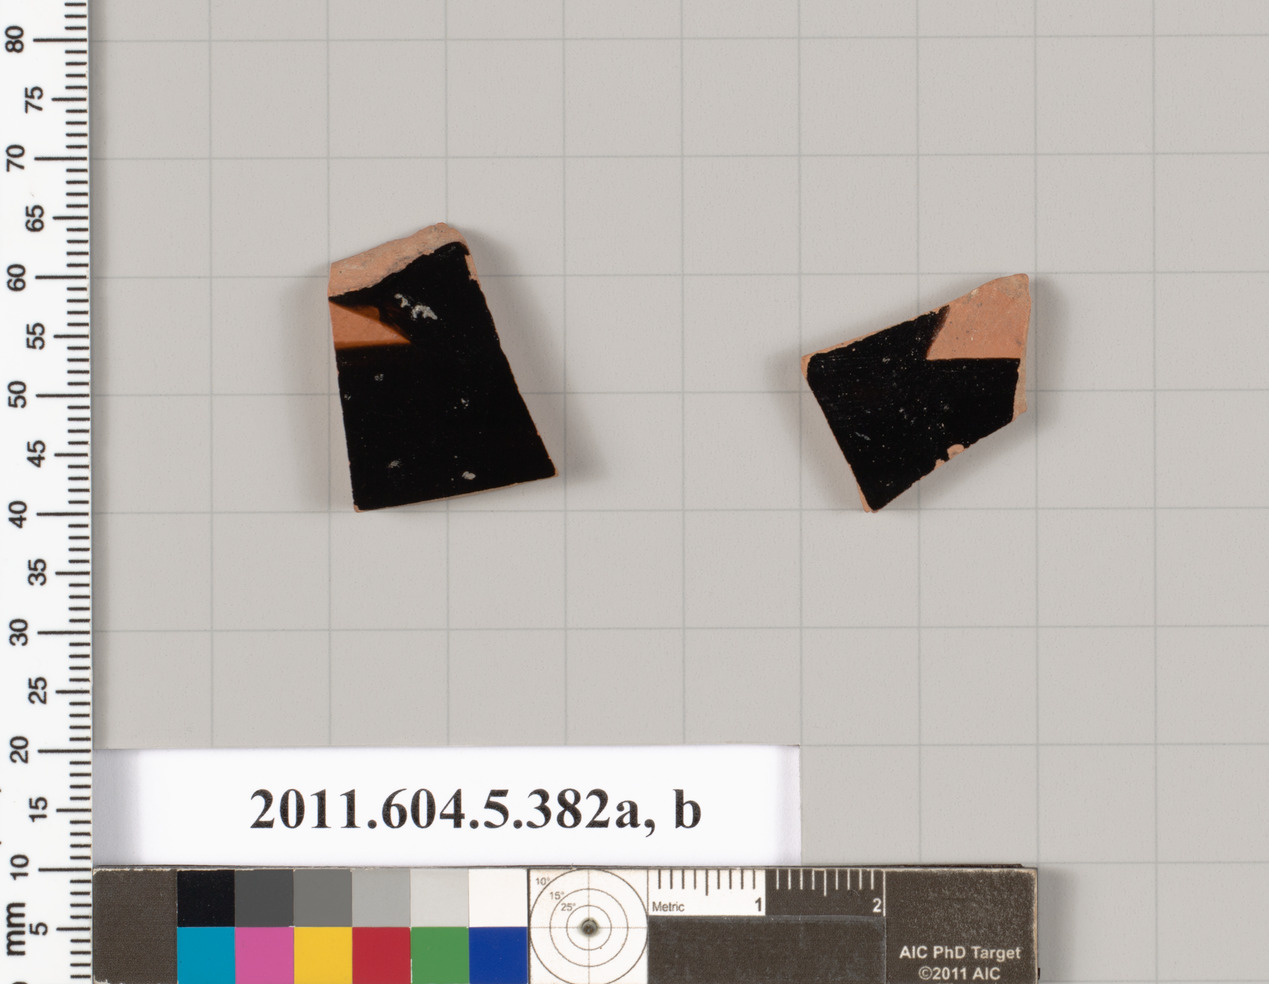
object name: kylix fragment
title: Terracotta fragments of kylikes (drinking cups)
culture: greek, attic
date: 600-401 BCE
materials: terracotta